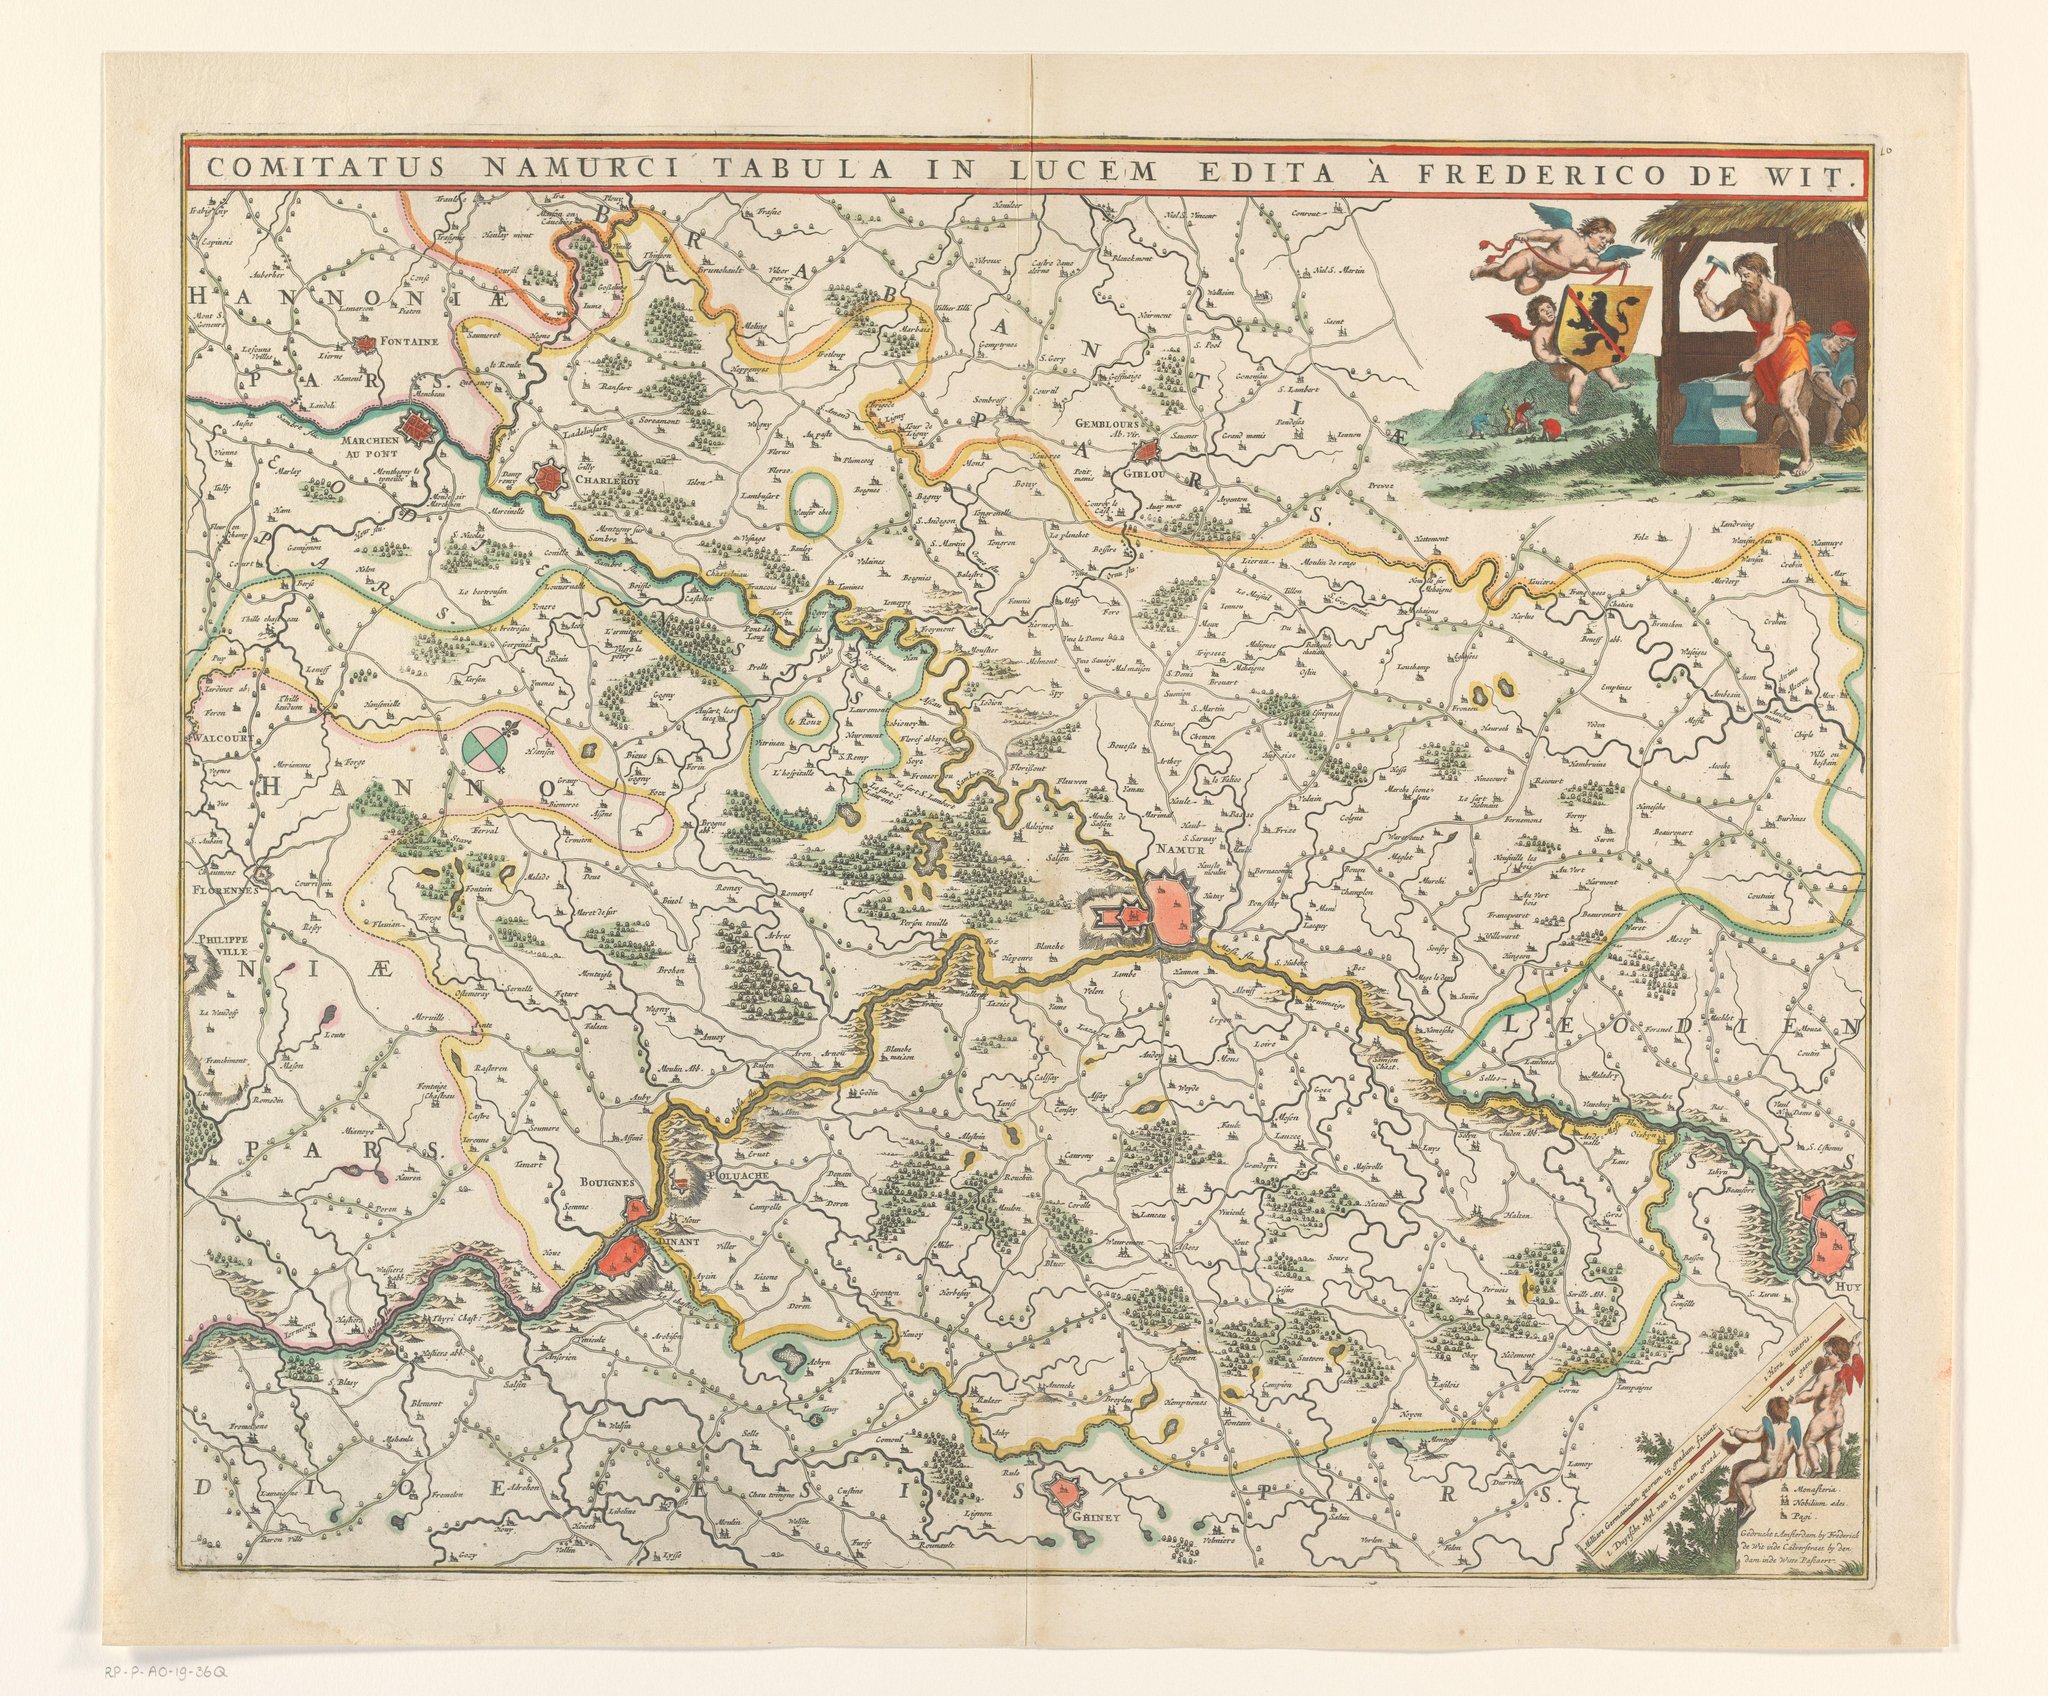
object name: print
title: Kaart van het graafschap Namen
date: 1666-1670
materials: paper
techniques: engraving, etching, hand coloring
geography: amsterdam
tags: maps of separate countries or regions, smith, blacksmith, coat of arms (as symbol of the state, etc.) (+ province; provincial)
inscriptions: collector's mark: Lugt 2228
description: Kaart van het graafschap Namen. In een balk boven de kaart de titel. Rechtsboven het wapen van Henegouwen, gedragen door twee putti bij een smederij. Rechtsonder twee putti met een schaalstok: 1 Duytsche Mijl van 15 in een Graad / 1 uur gaens.